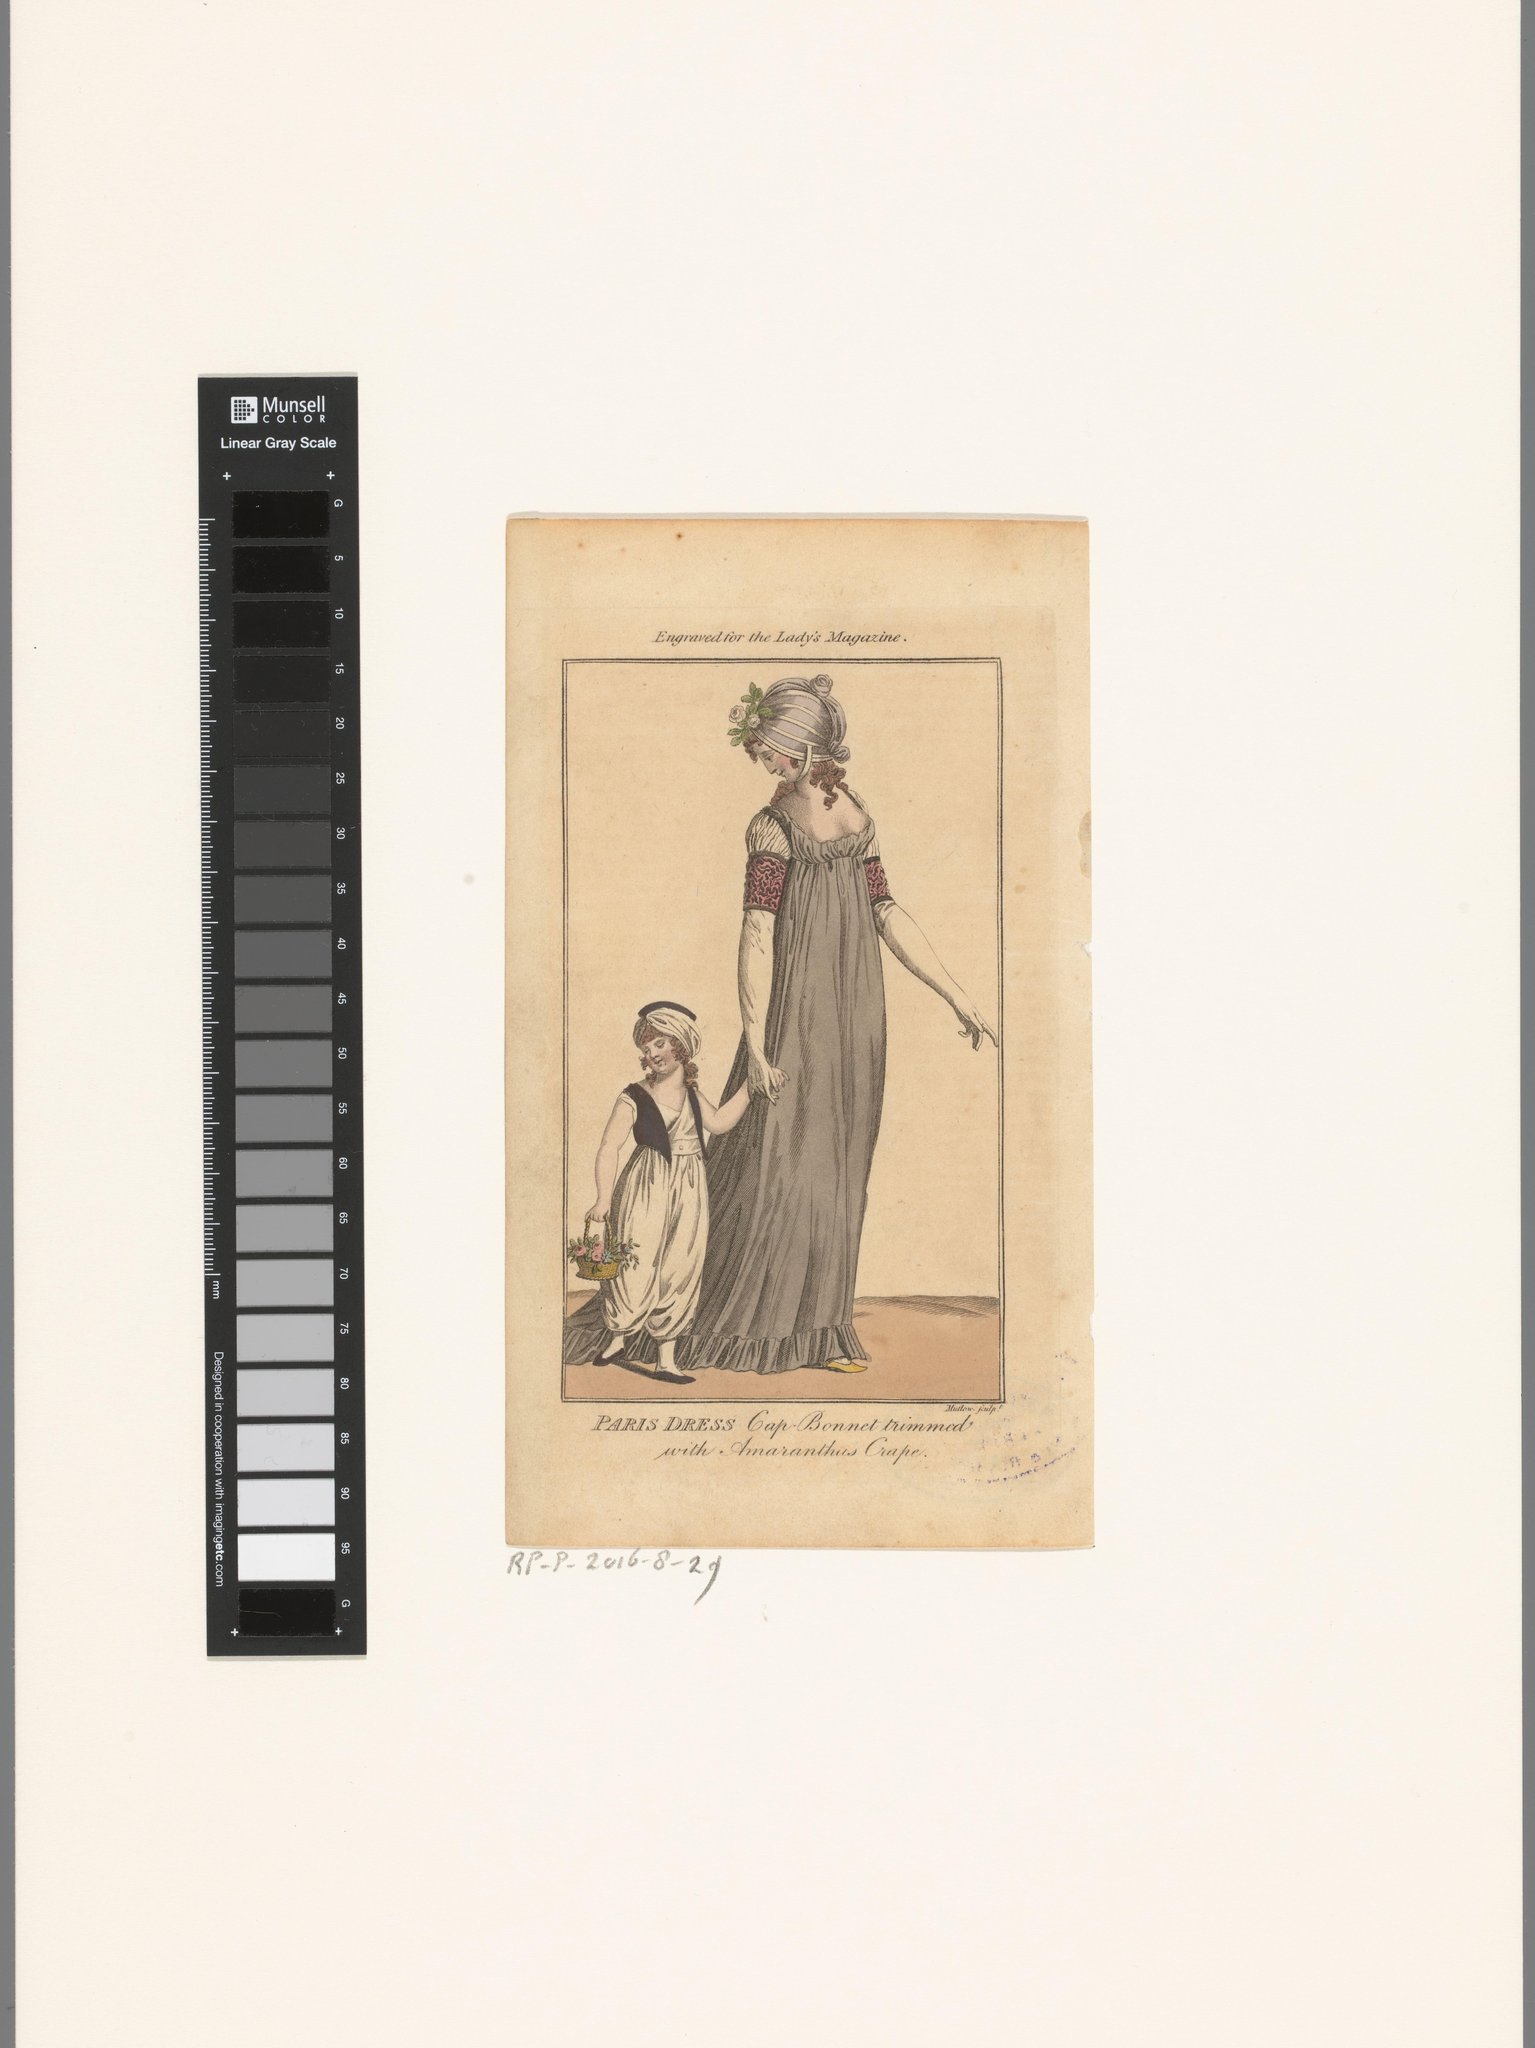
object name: fashion print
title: Magazine of Female Fashions of London and Paris, PARIS DRESS. Cap-Bonnet (...)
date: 1798-1806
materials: paper, ink, watercolor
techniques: engraving, etching, hand coloring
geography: london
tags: gloves, mittens (long gloves) (+ women's clothes), fashion plates, dress, gown (+ women's clothes), bracelet, wristlet (+ women's clothes)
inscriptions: collector's mark: Lugt 2228, stamp: ‘Marcelle Demay Modes Paris, 11, Rue Royale, 11’, caption: ‘Engraved for the Lady's Magazine’, collector's mark: ‘Marcelle Demay Modes Paris 11, Rue Royale, 11’, caption, gegraveerd: ‘PARIS DRESS. Cap-Bonnet trimmed with Amaranthus Crape’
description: Jonge vrouw in Parijse japon. Op het hoofd een 'cap-bonnet' afgezet met Amaranthus band. Lange handschoenen. Aan de hand een kind. Kopie naar een prent uit Journal des Dames et des Modes.